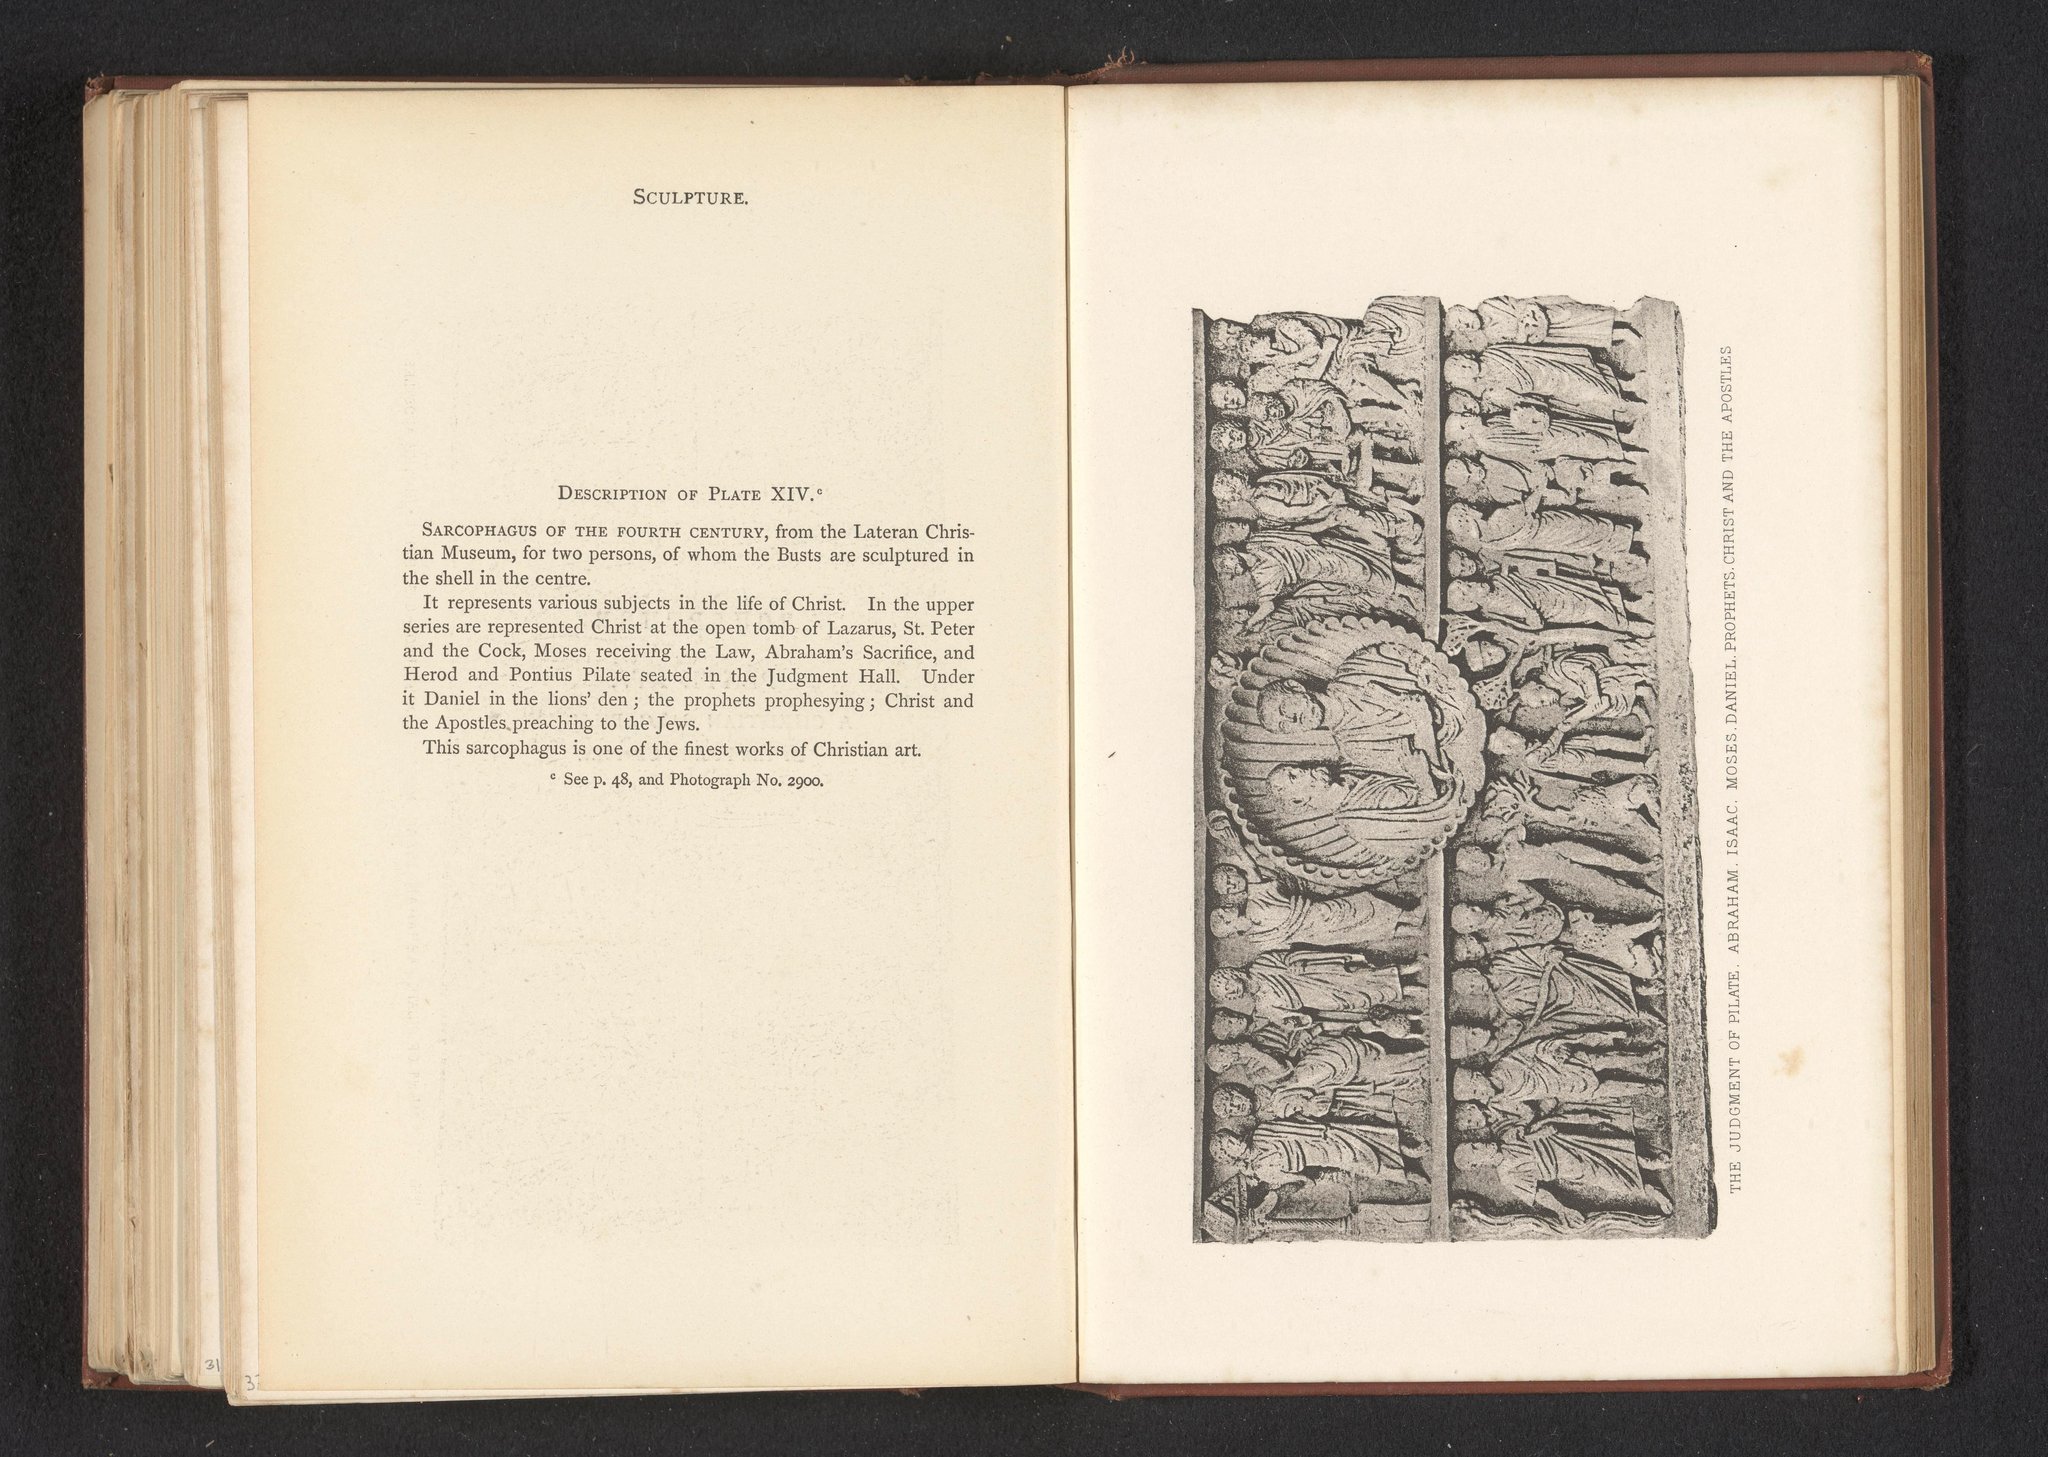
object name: page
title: The judgment of Pilate. Abraham, Isaac, Moses, Daniel, Prophets, Christ and the Apostles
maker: Anonymous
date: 1867-1877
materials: paper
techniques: photoaquatint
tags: sarcophagus, decorating 'en relief', appliquéing, pilate showing christ to the people, 'ostentatio christi', 'ecce homo' (john 19:4-6)